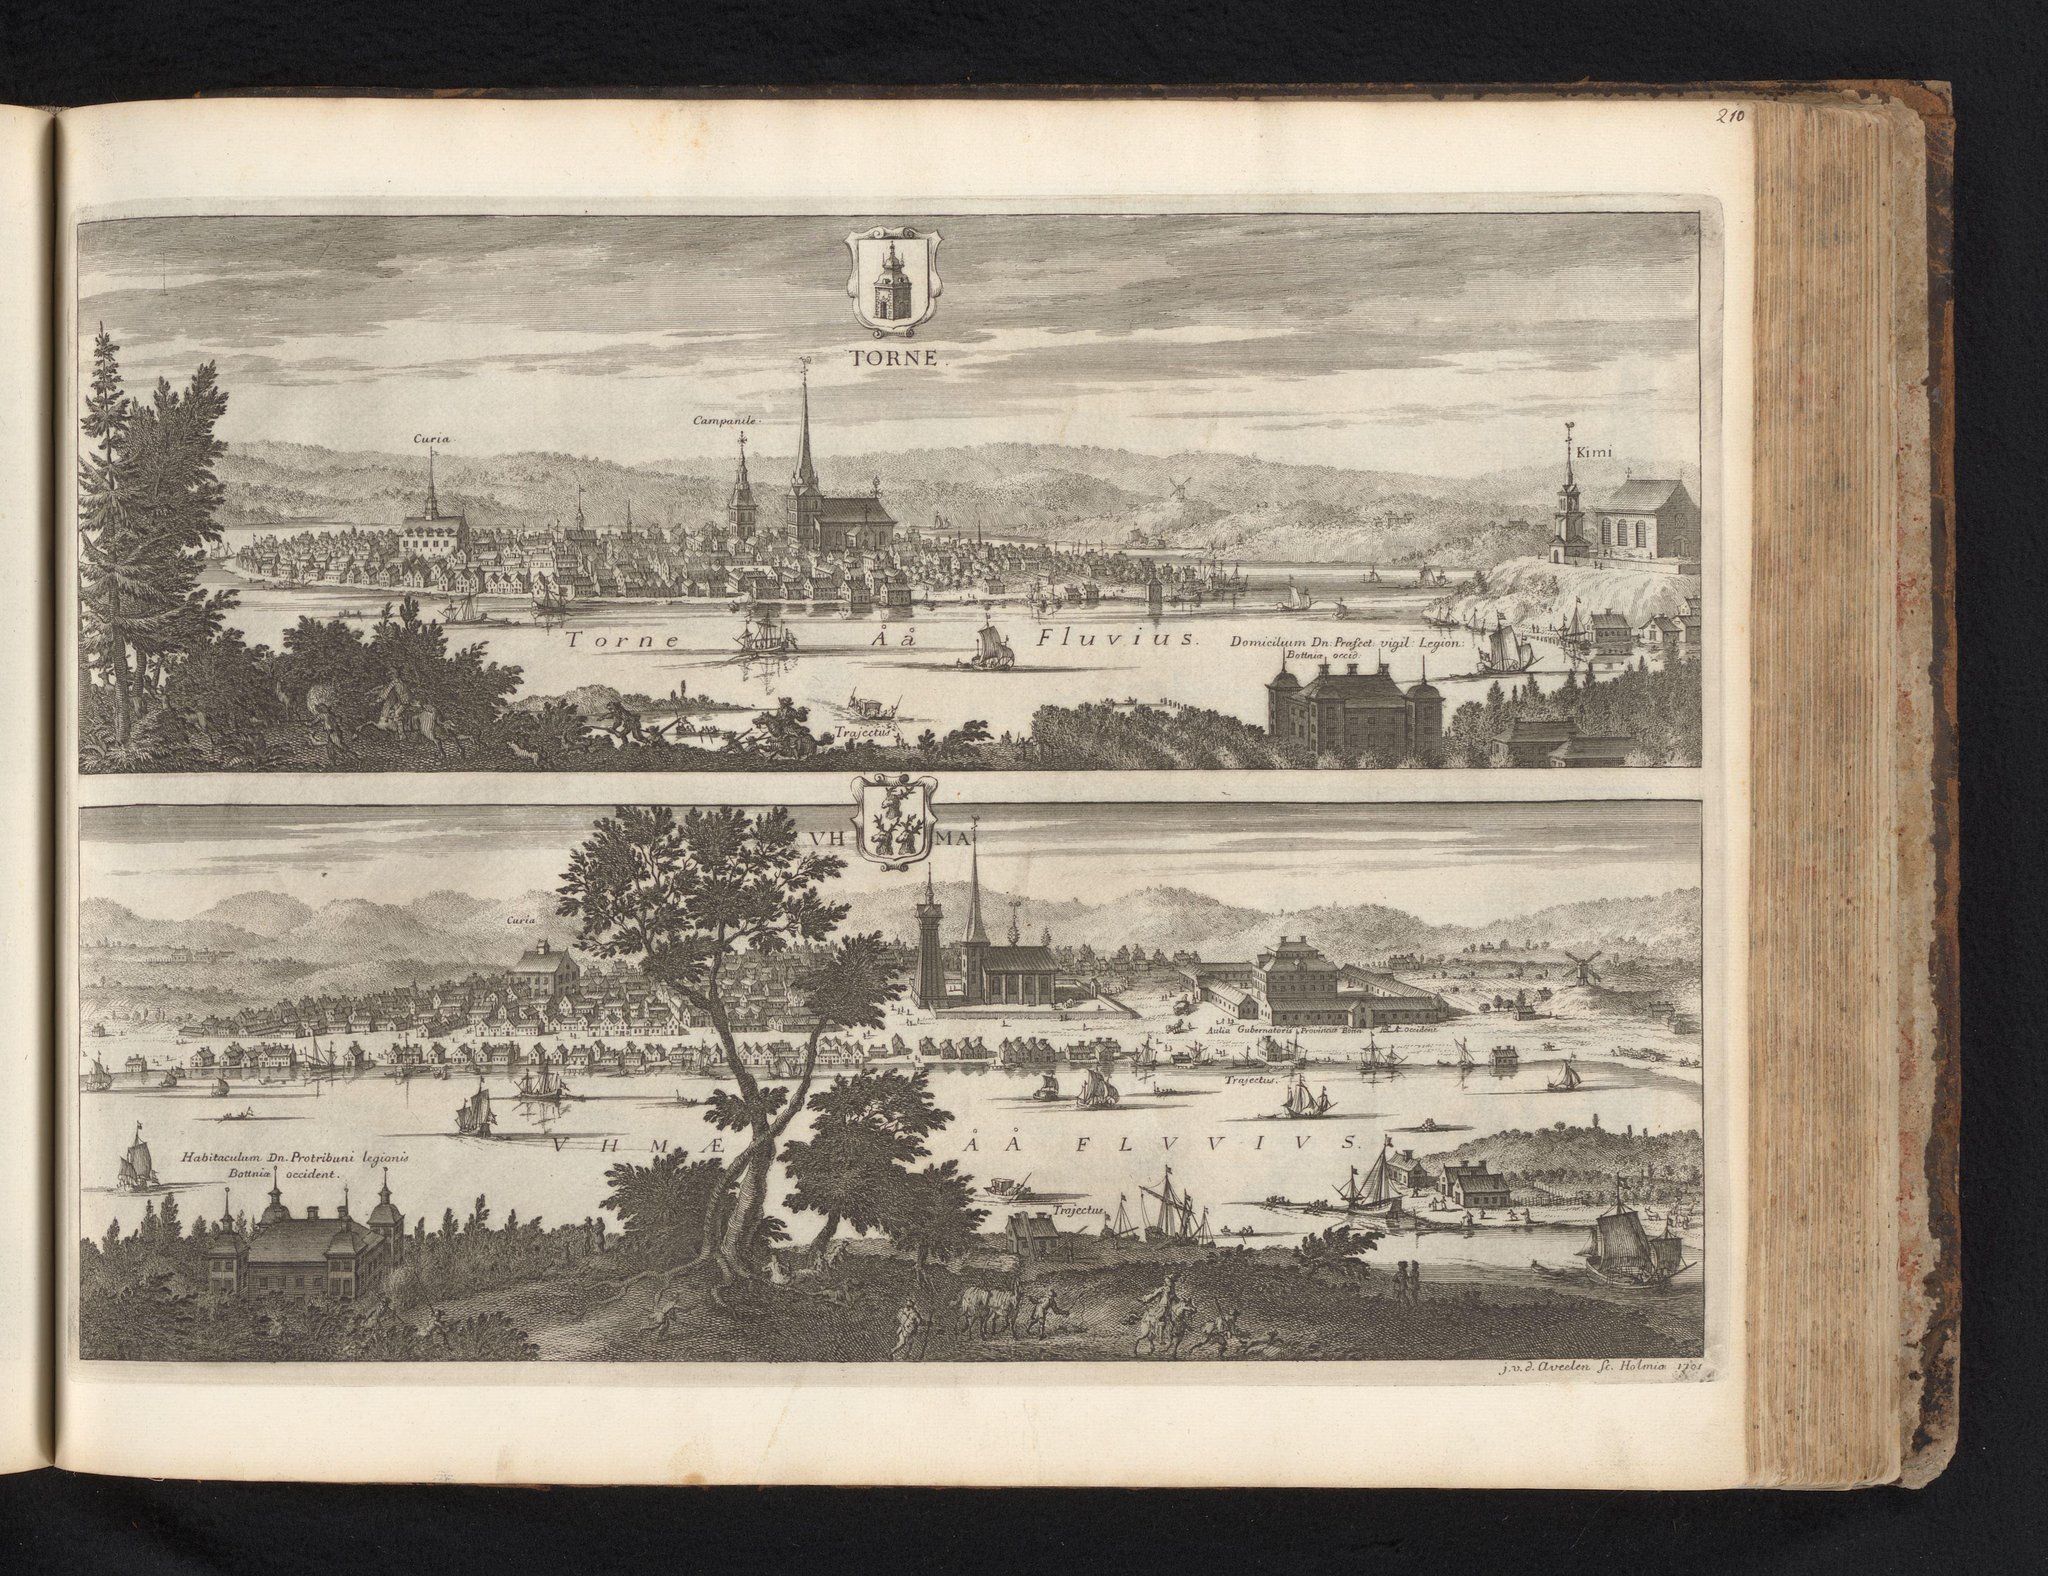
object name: print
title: Torne / Uhma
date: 1701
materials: paper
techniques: etching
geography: stockholm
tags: city-view in general; 'veduta'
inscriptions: date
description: Kungliga Biblioteket, 'Suecia': http://www.kb.se/samlingarna/Kartor-bilder/Suecia-antiqua/ (geraadpleegd november 2016).